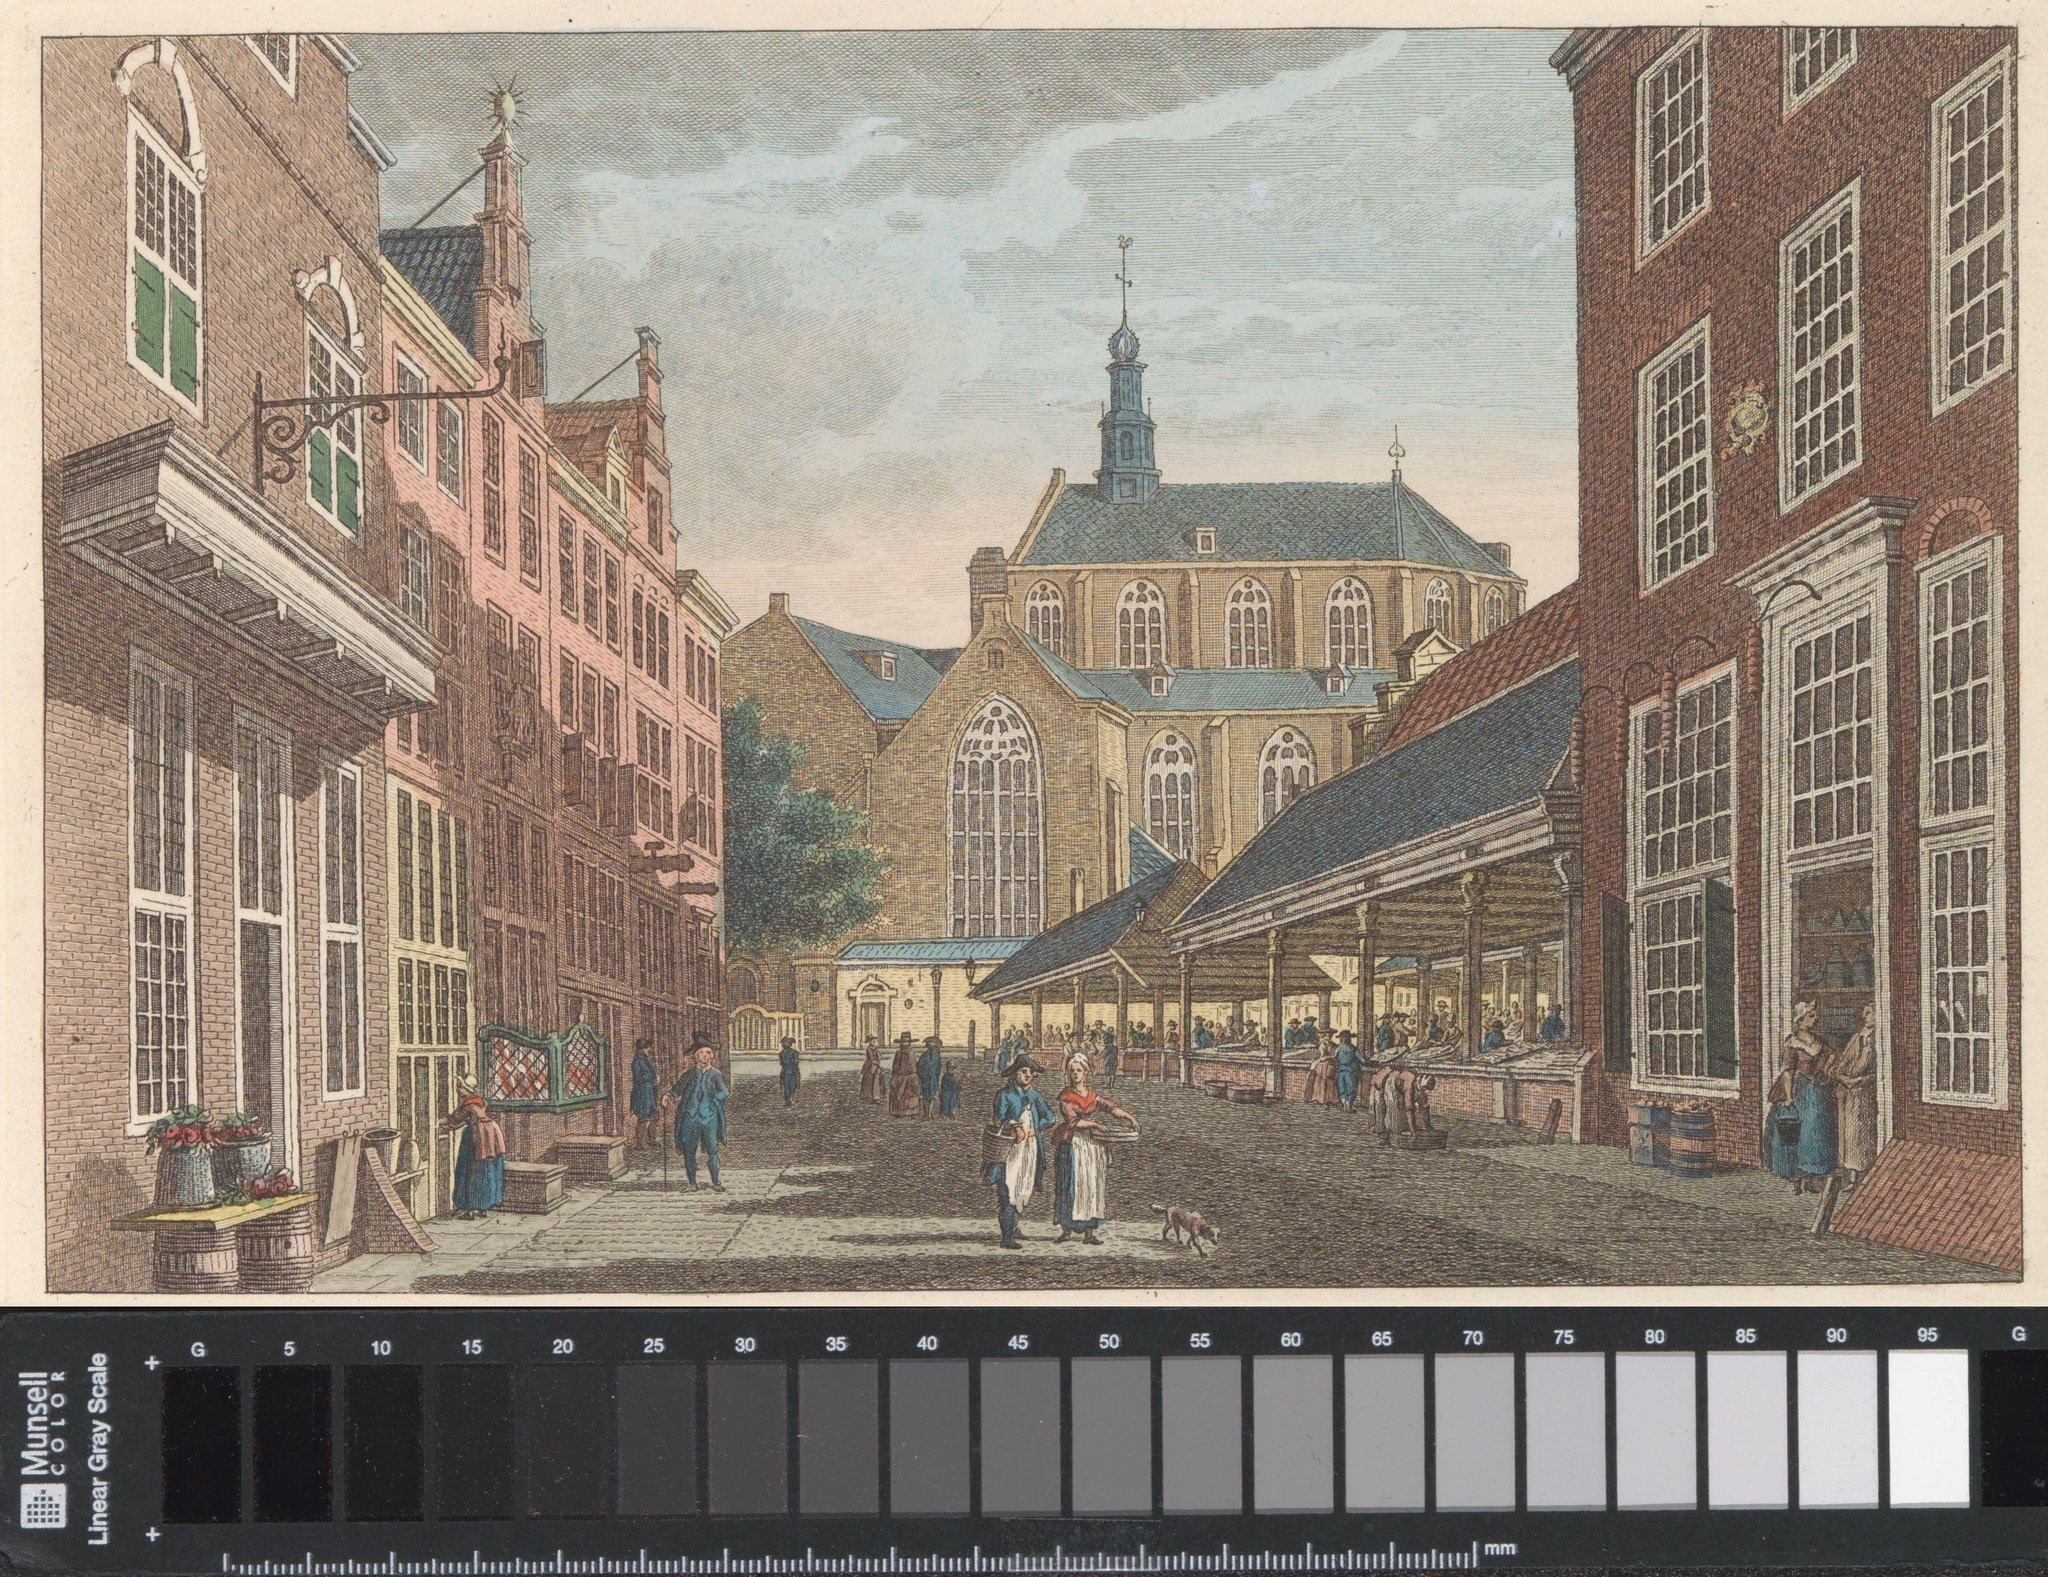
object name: print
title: De Vischmarkt en groote Kerk in s'Hage / Vue dela poissonnerie et dela grande Eglise à la haye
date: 1786-1792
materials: paper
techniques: engraving, etching, hand coloring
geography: amsterdam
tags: visbanken, grote kerk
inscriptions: inscription: ‘Vue dela poissonnerie et dela grande Eglise à la haye / 23 / chez E: Maaskamp à Amsterdam’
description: Huidige staat van prent uitgegeven als onderdeel van een plaatwerk uit ca. 1824-1825 met 74 (ongenummerde) platen van de belangrijkste topografische gezichten en verschillende zeden en gewoonten in het Verenigd Koninkrijk der Nederlanden, getiteld 'Tableau des principales vues des palais et édifices : représentations et des coutumes et usages, dans les provinces septentrionales du Royaume des Pays-Bas'. Eerdere staat gebruikt in: Vaderlandsche gezichten, of afbeeldingen van den tegenwoordigen staat der Vereenigde Nederlanden (…). Amsterdam: Hendrik Gartman, Willem Vermandel en Jan Willem Smit, 1786-1792. Uitgegeven in afleveringen met ieder een eigen bifolium en inhoudsopgave. Alle prenten in deze publicatie zijn gegraveerd door Carel Frederik Bendorp (I) en, in de meeste gevallen, gebaseerd op tekeningen van Jan Bulthuis.